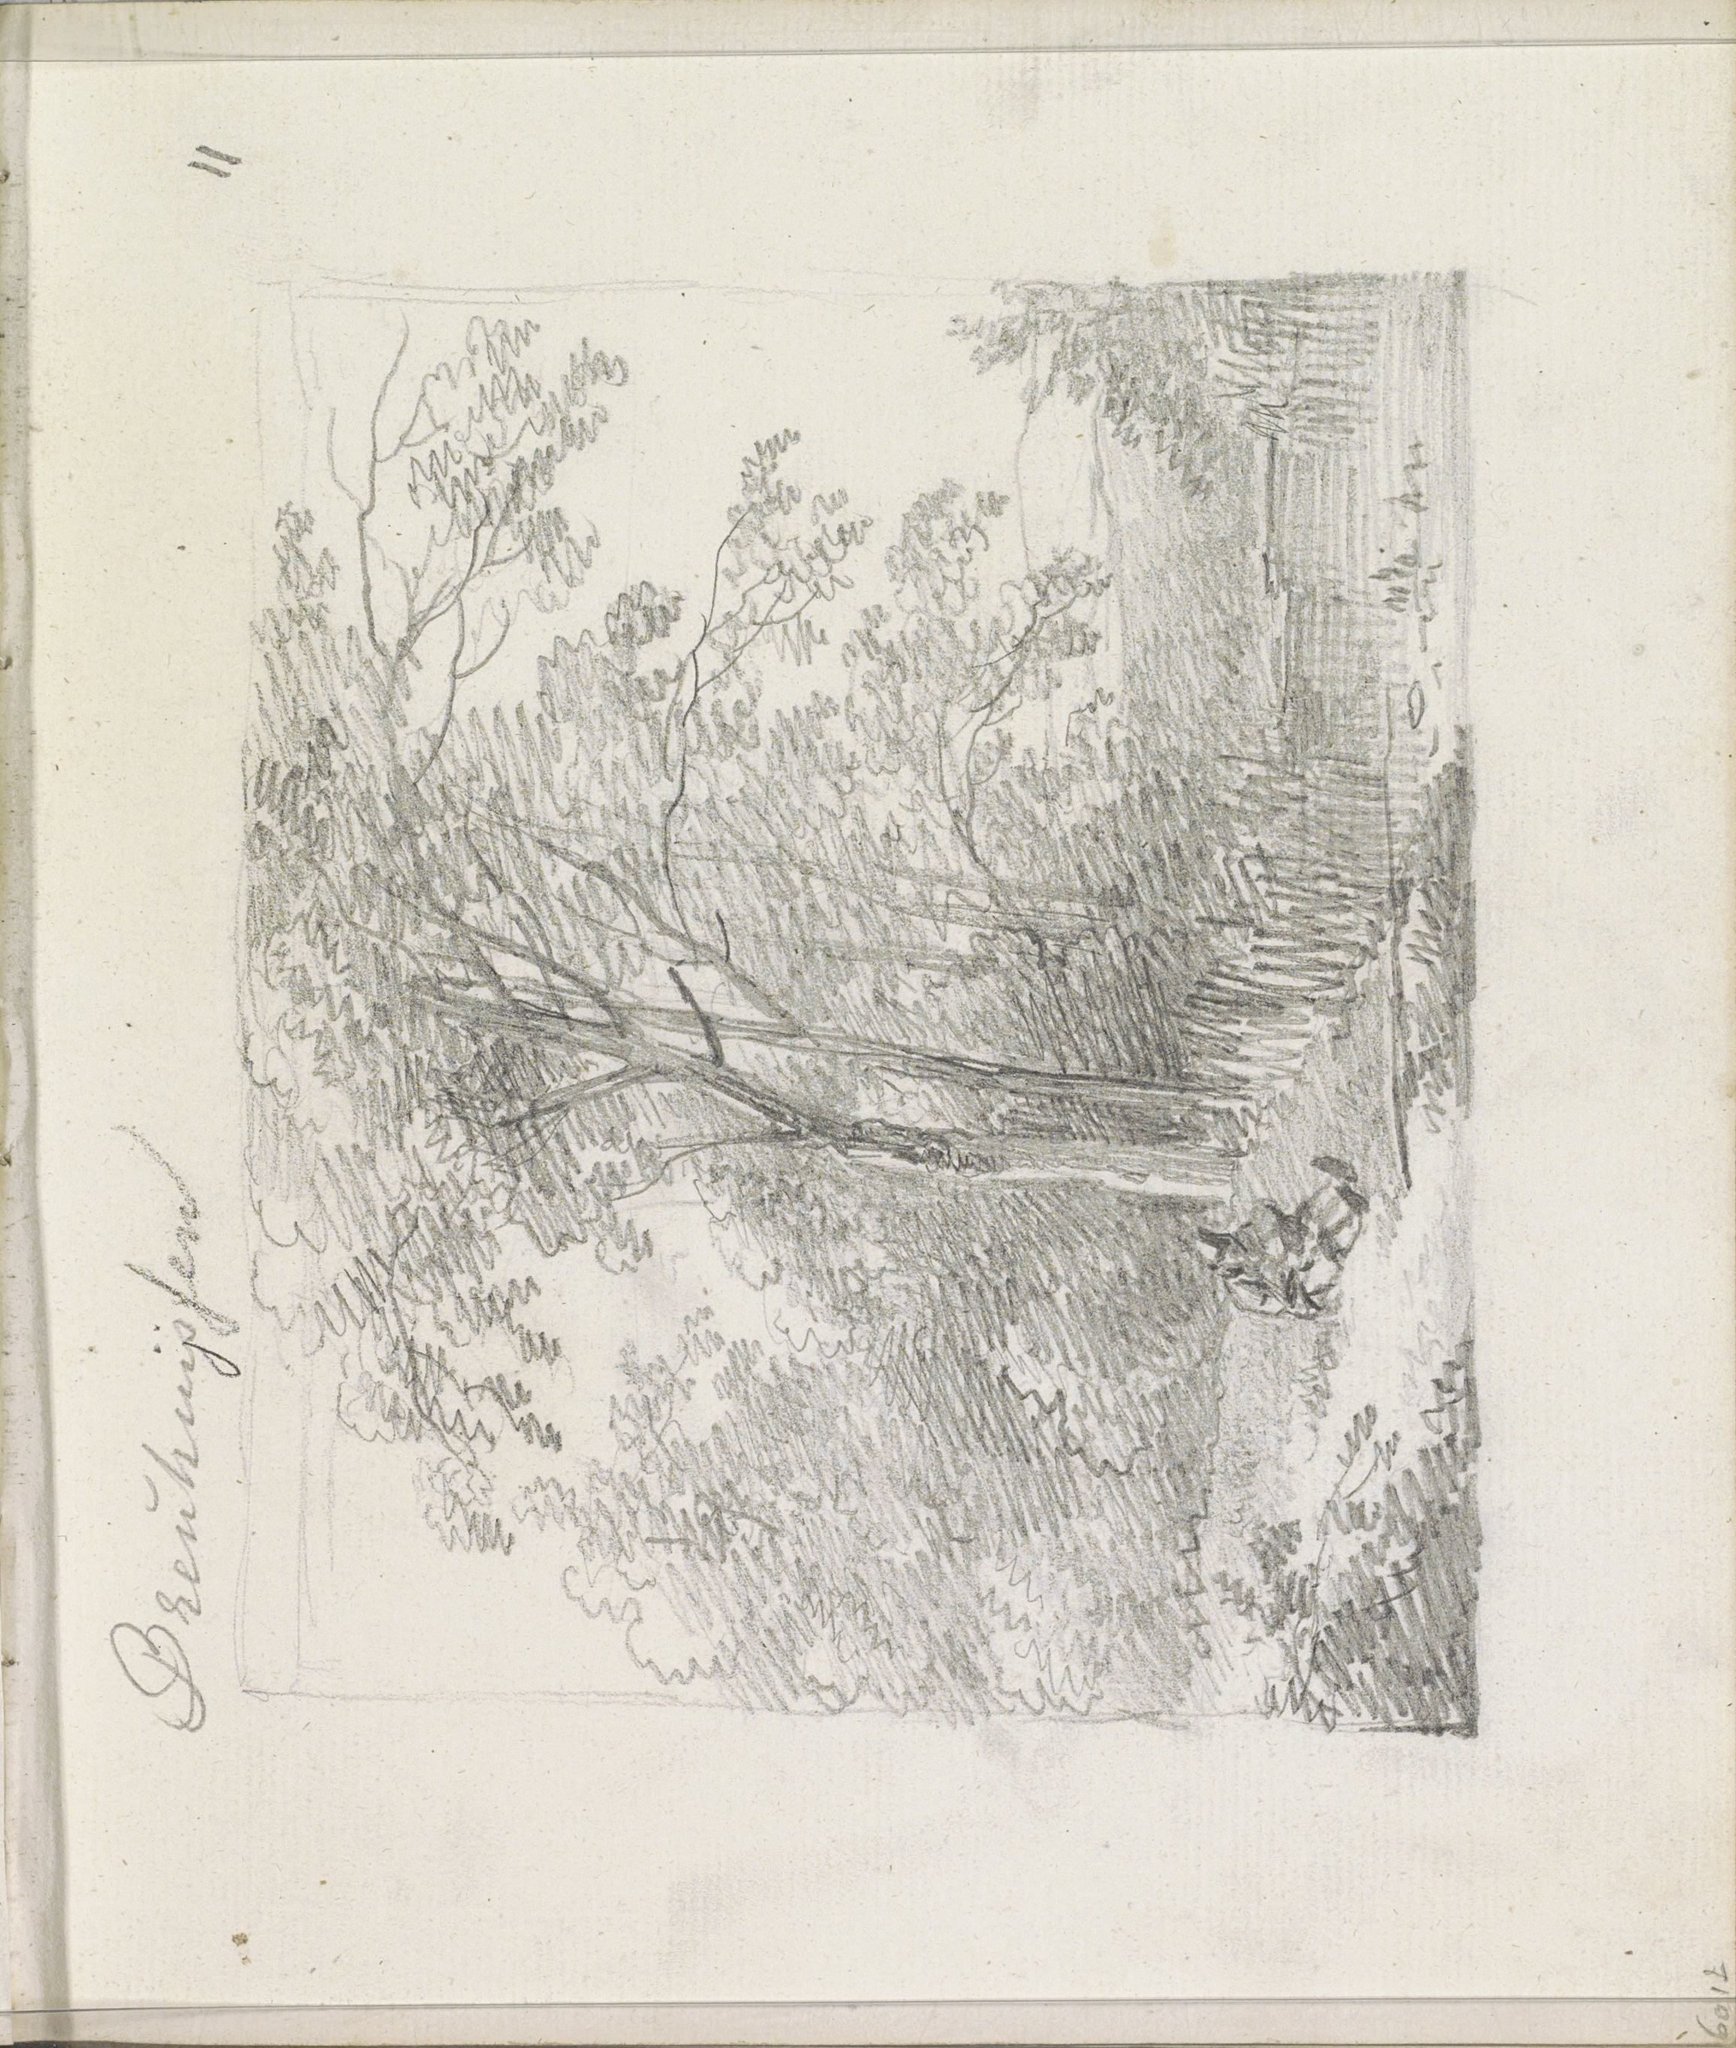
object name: sketchbook leaf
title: Zittende man aan een waterkant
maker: andreas schelfhout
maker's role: draughtsman, painter, print maker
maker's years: 1787-1870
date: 1825-1829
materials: paper, pencil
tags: landscapes with waters, waterscapes, seascapes (in the temperate zone) (+ landscape with figures, staffage)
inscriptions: annotation: ‘Brenhuijssen’, number: ‘11/ 6012’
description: Blad 25 recto uit een schetsboek met 95 bladen.